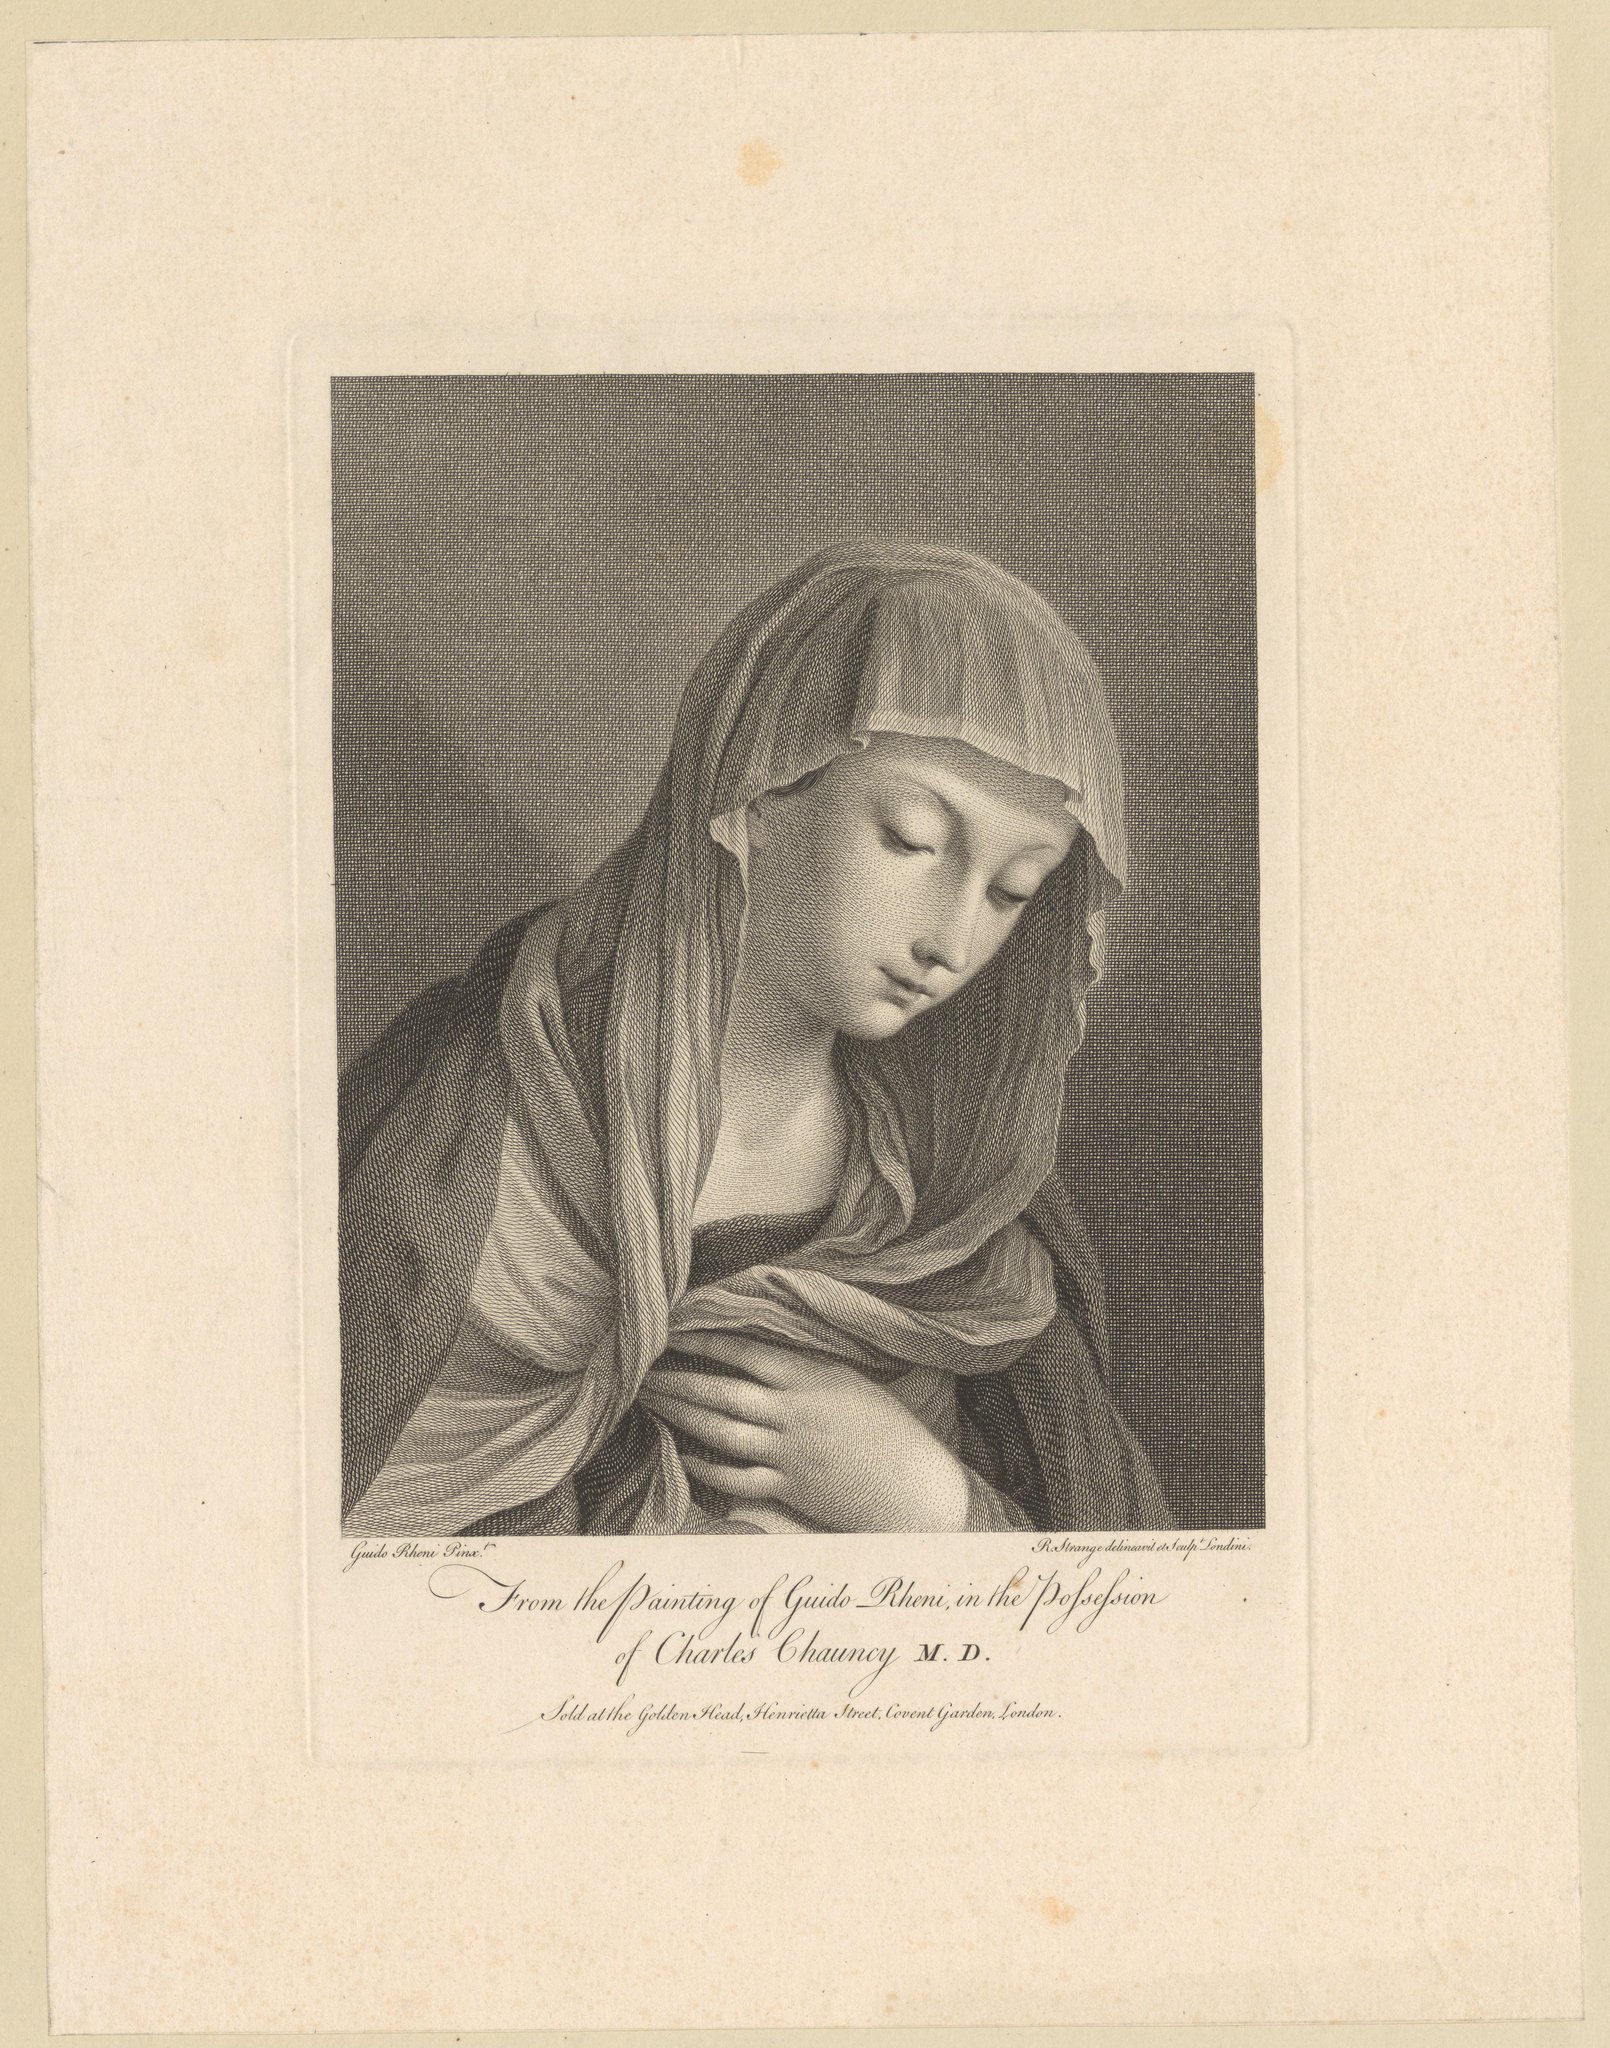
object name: print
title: Maria van de Annunciatie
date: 1765-1769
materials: paper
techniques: engraving, etching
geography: london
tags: 'portraits' of mary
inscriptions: collector's mark: Lugt 240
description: Prent vormt een paar met RP-P-OB-19.024, de aartsengel Gabriël.